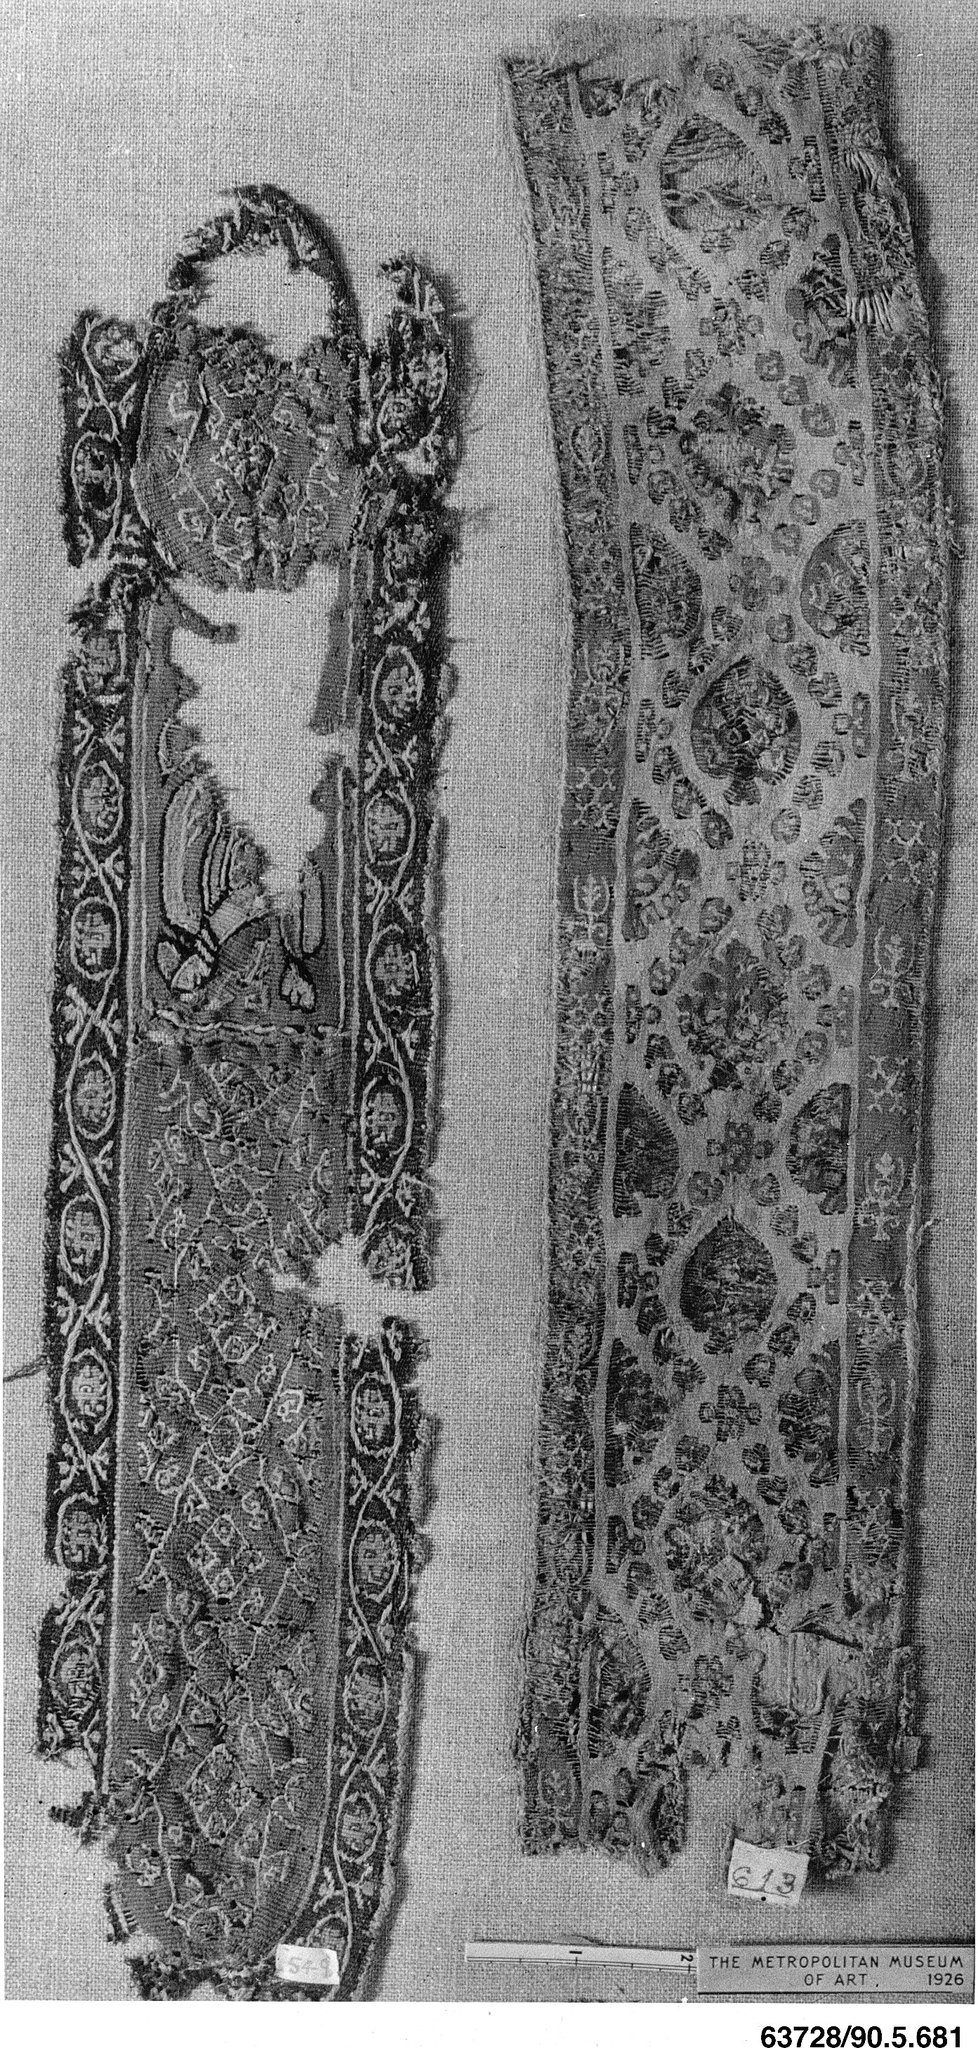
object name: textile fragment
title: Fragment of Shoulder Band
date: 401-500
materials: linen, wool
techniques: weave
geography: egypt